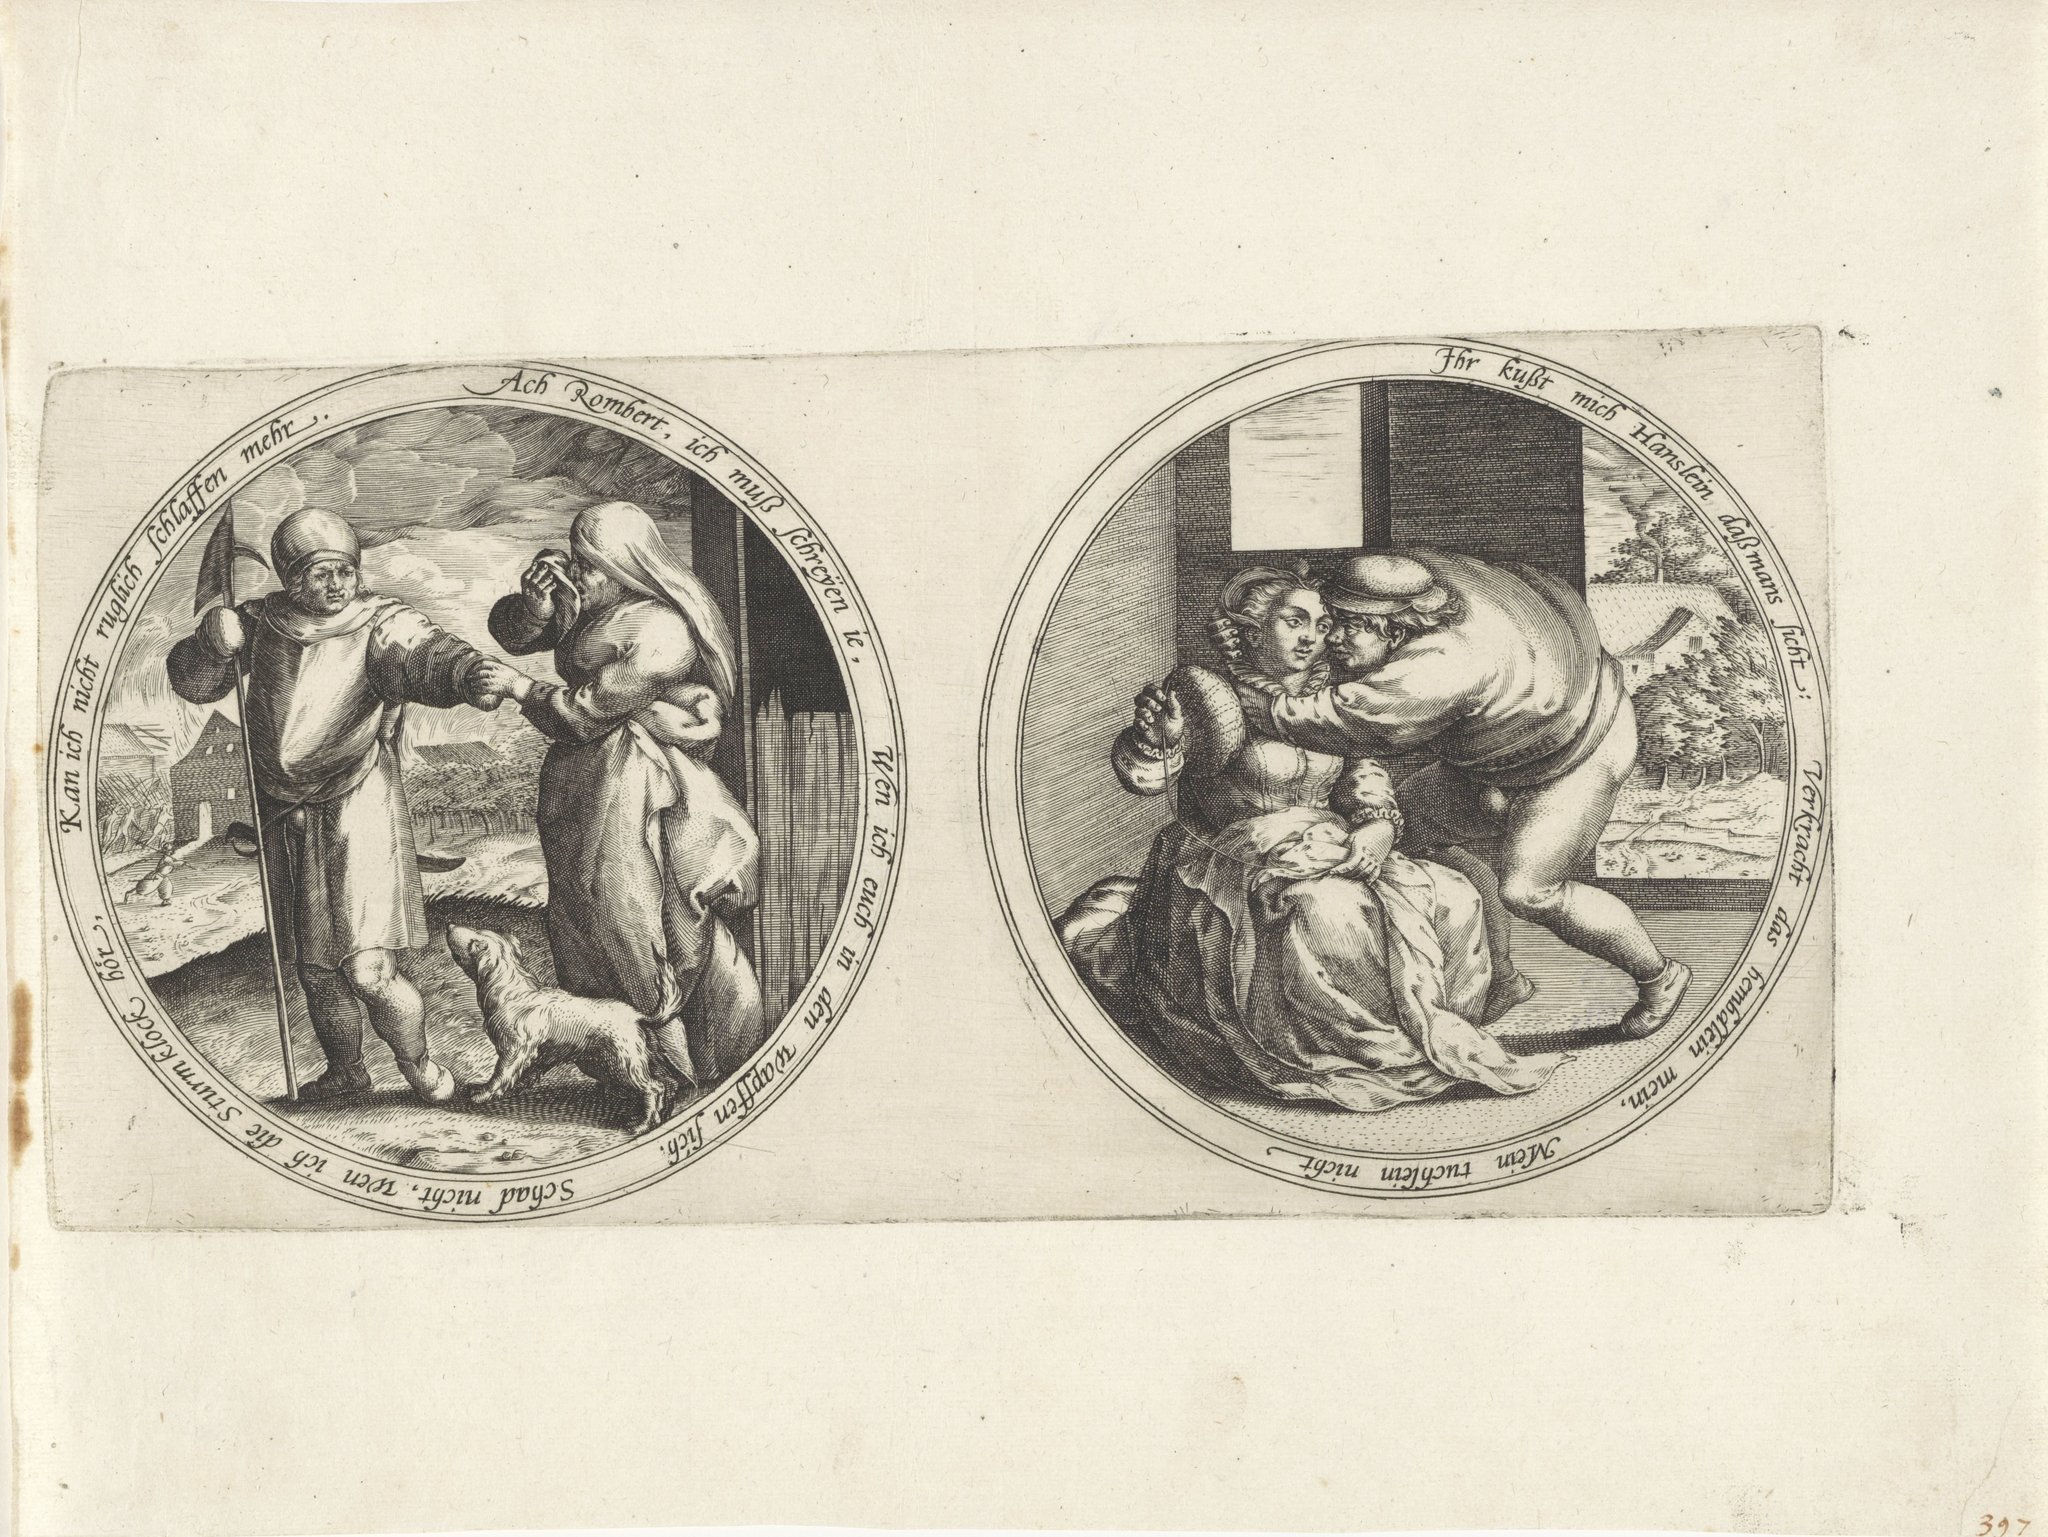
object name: print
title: Afscheid van een soldaat en man benadert een naaister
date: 1555-1631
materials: paper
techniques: engraving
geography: southern netherlands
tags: image of phallus, 'phallos', embracing each other, kissing, crying, shouting, leave-taking (of soldiers), sewing, dog, sensuality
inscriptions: collector's mark: Lugt 4099, collector's mark: Lugt 2228, collector's mark: Lugt 2760, number: Lugt 397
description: Twee medaillons met een dubbelzinnig randschrift in het Duits. Op het links medaillon neemt een huilende vrouw afscheid van haar man, die zich als soldaat bij het leger voegt. Tussen hen in staat een hond. Op het rechter medaillon zit een jonge vrouw in een sober vertrek te naaien. Voor haar staat een boer, die haar omhelst en op het punt staat om haar te kussen.